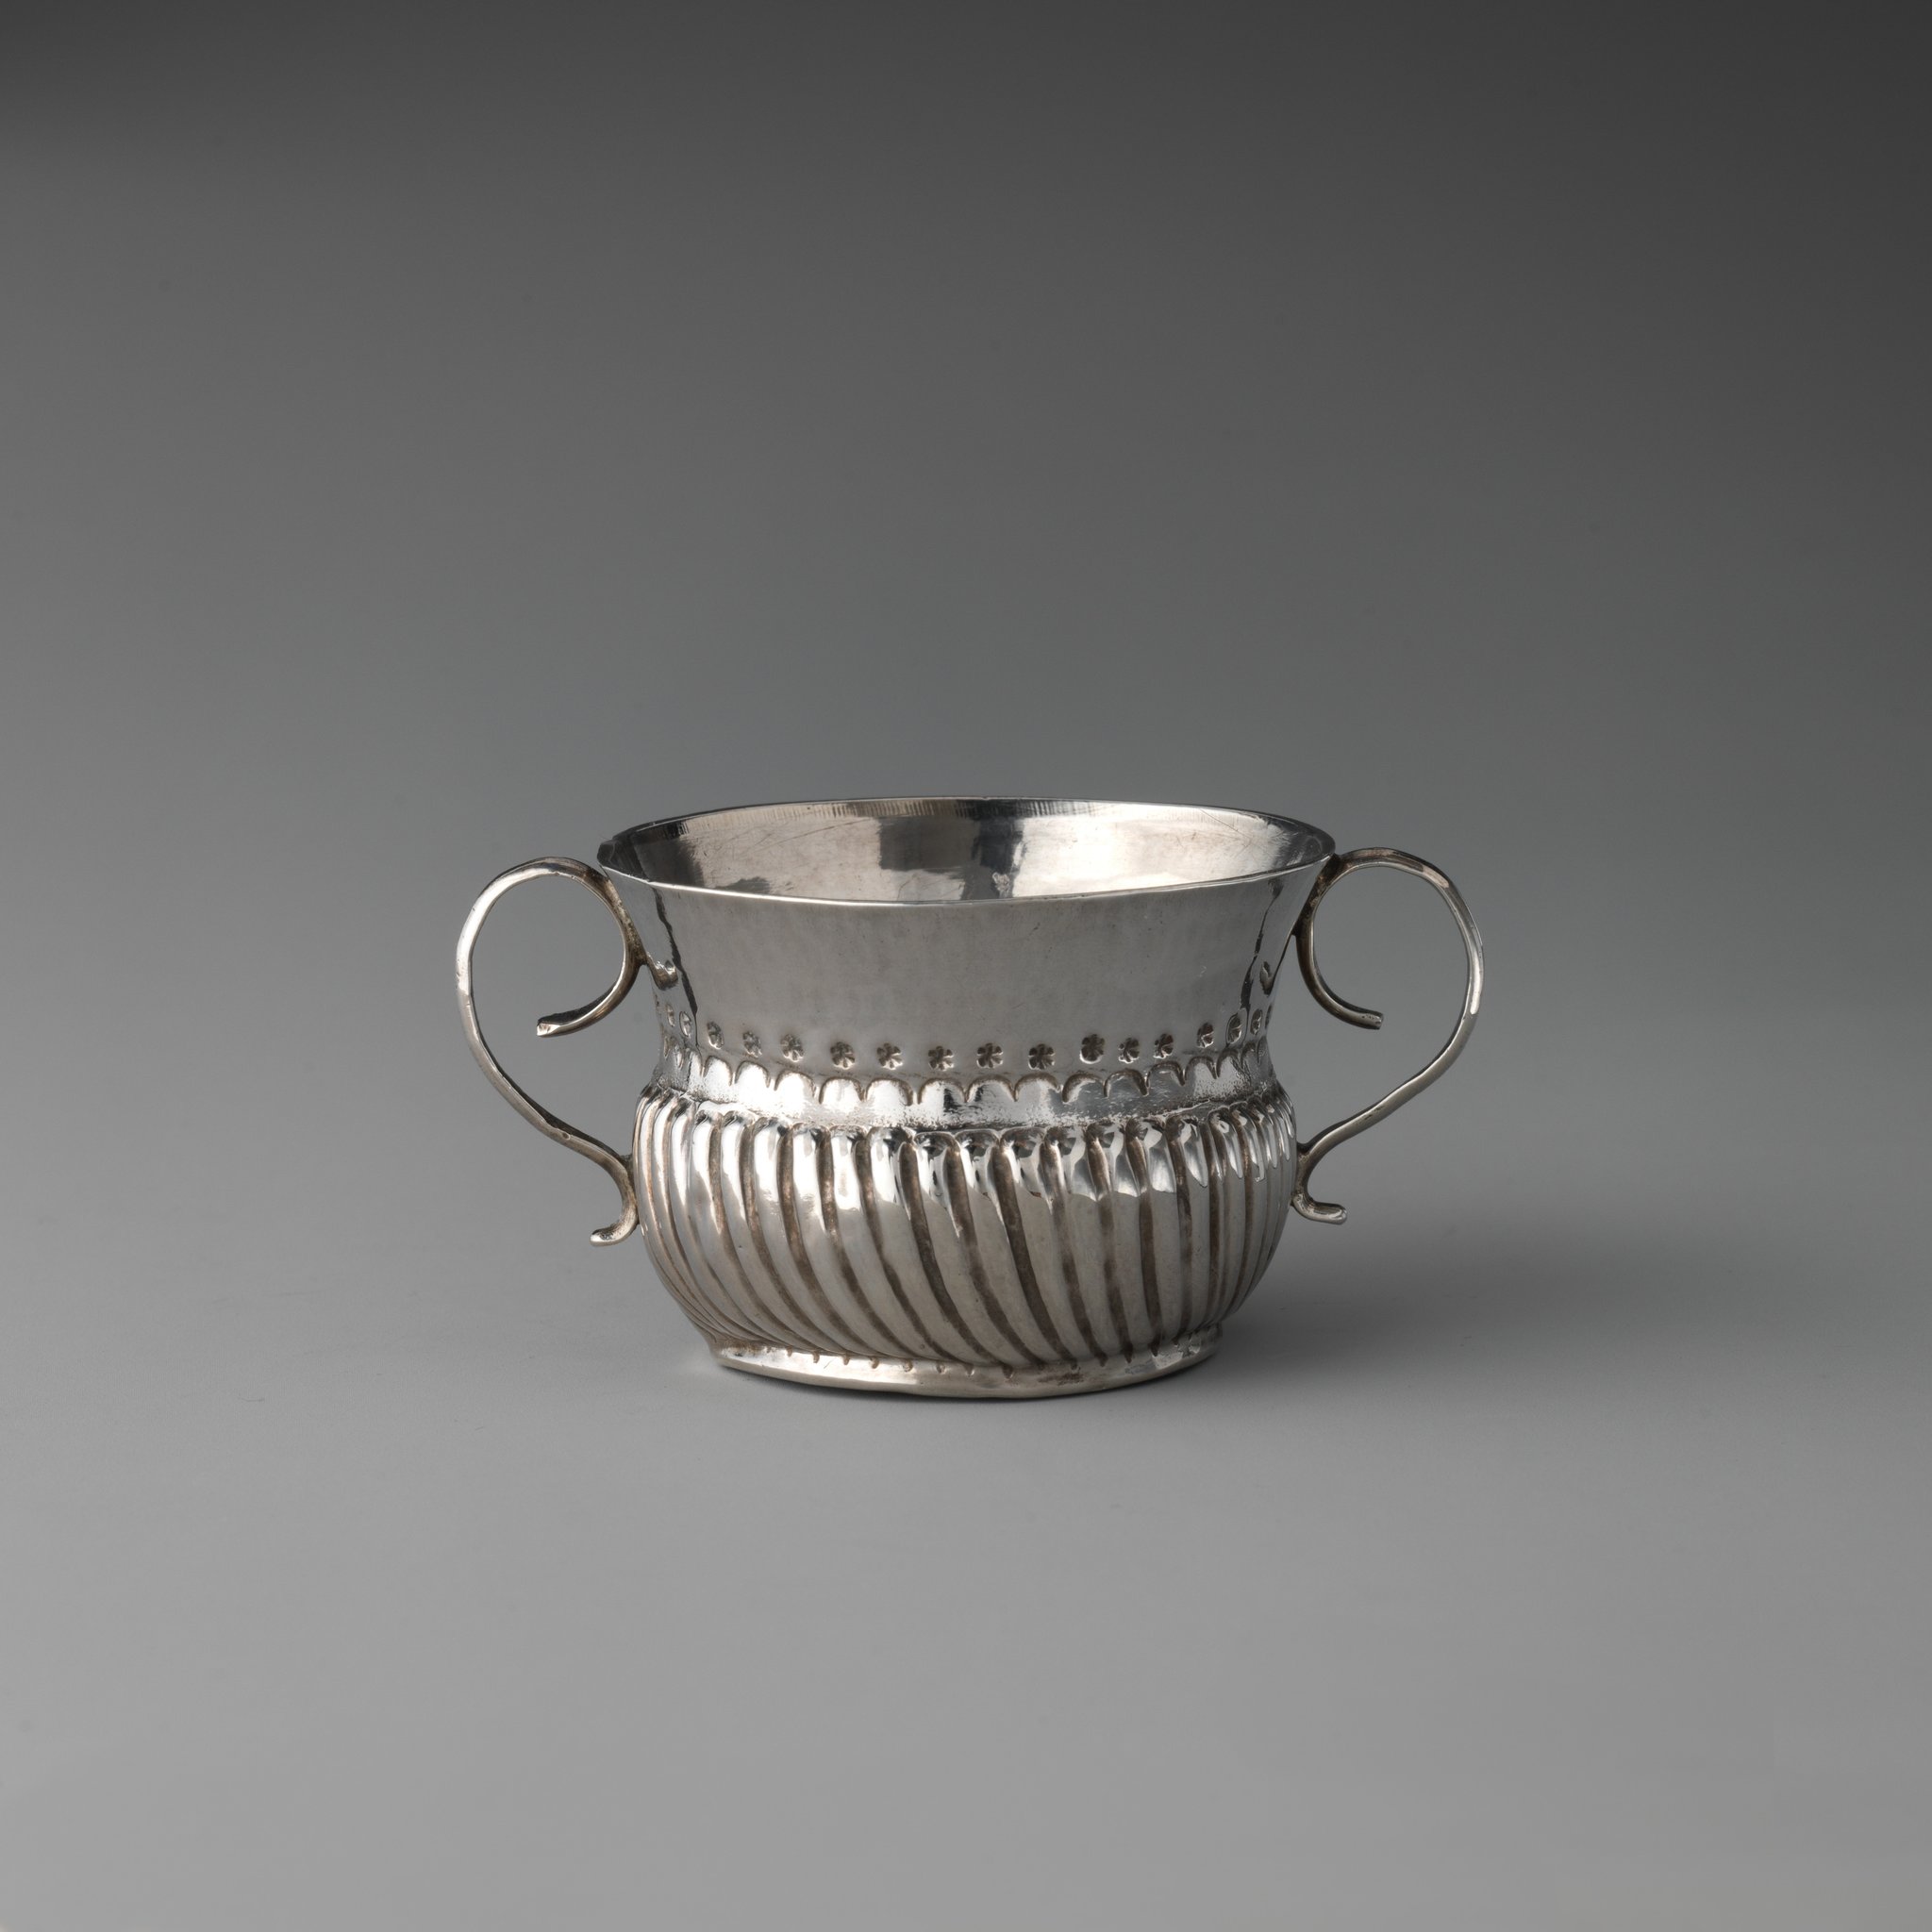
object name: porringer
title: Miniature porringer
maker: william flemming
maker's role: maker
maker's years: 1697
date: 1703-1704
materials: silver